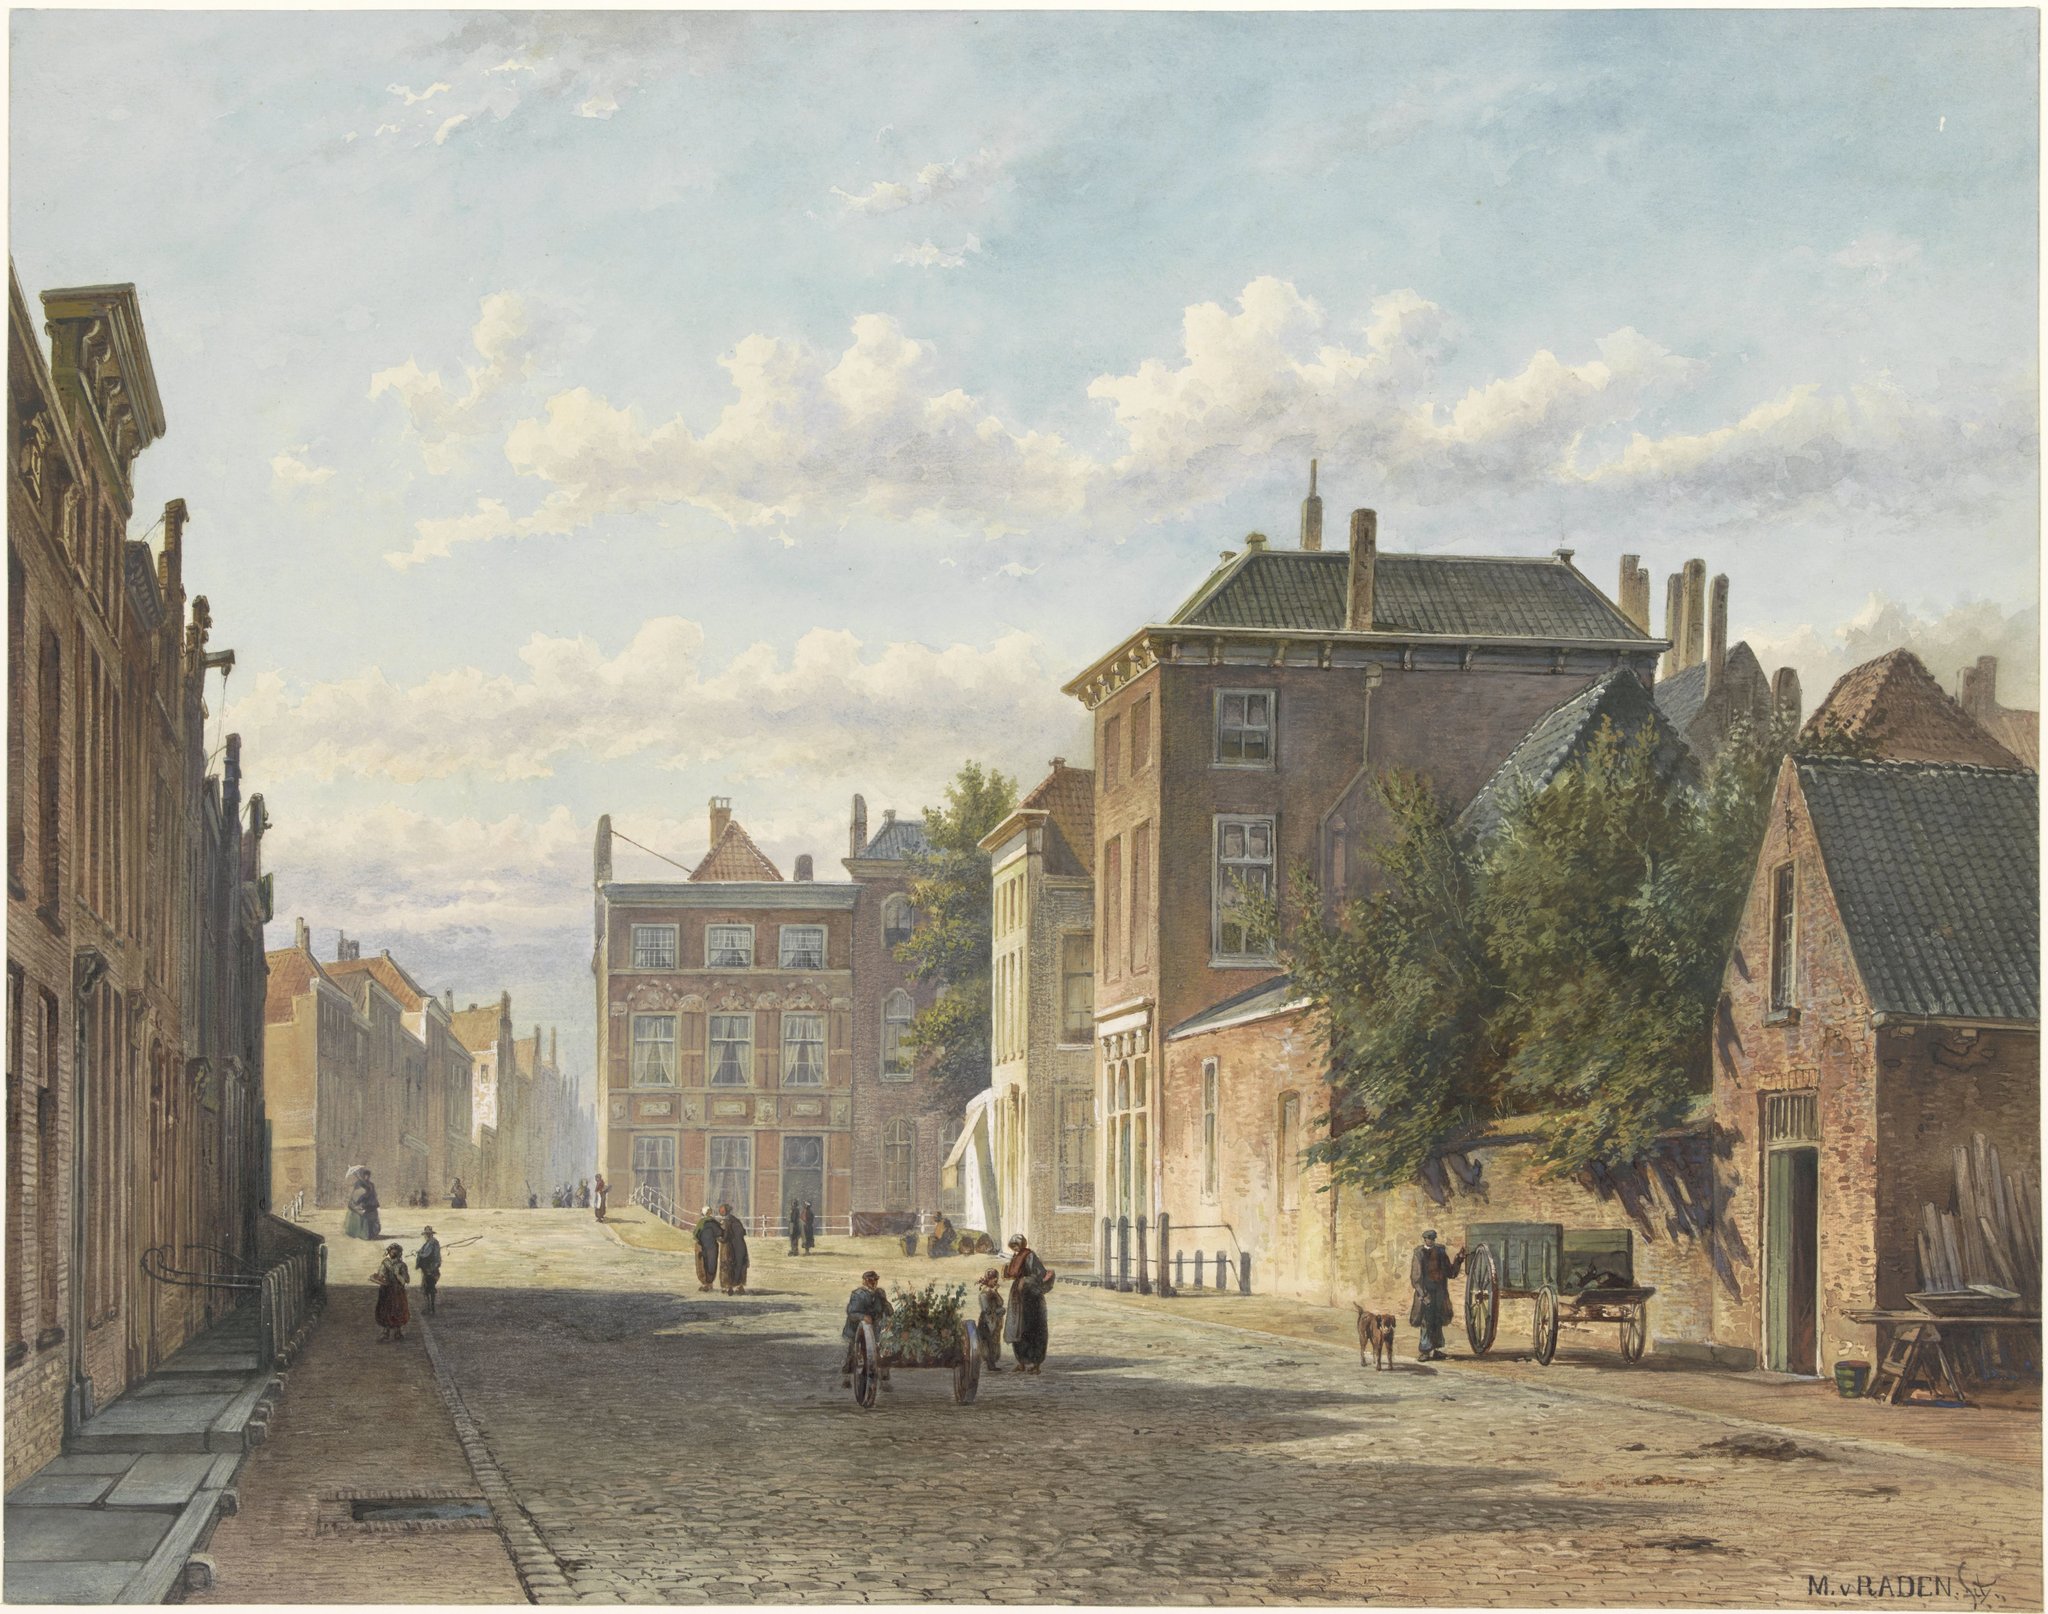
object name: watercolor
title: De Gedempte Burgwal te 's-Gravenhage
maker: marinus van raden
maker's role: draughtsman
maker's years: 1832-1879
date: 1842-1879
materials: paper, watercolor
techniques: brush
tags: public road